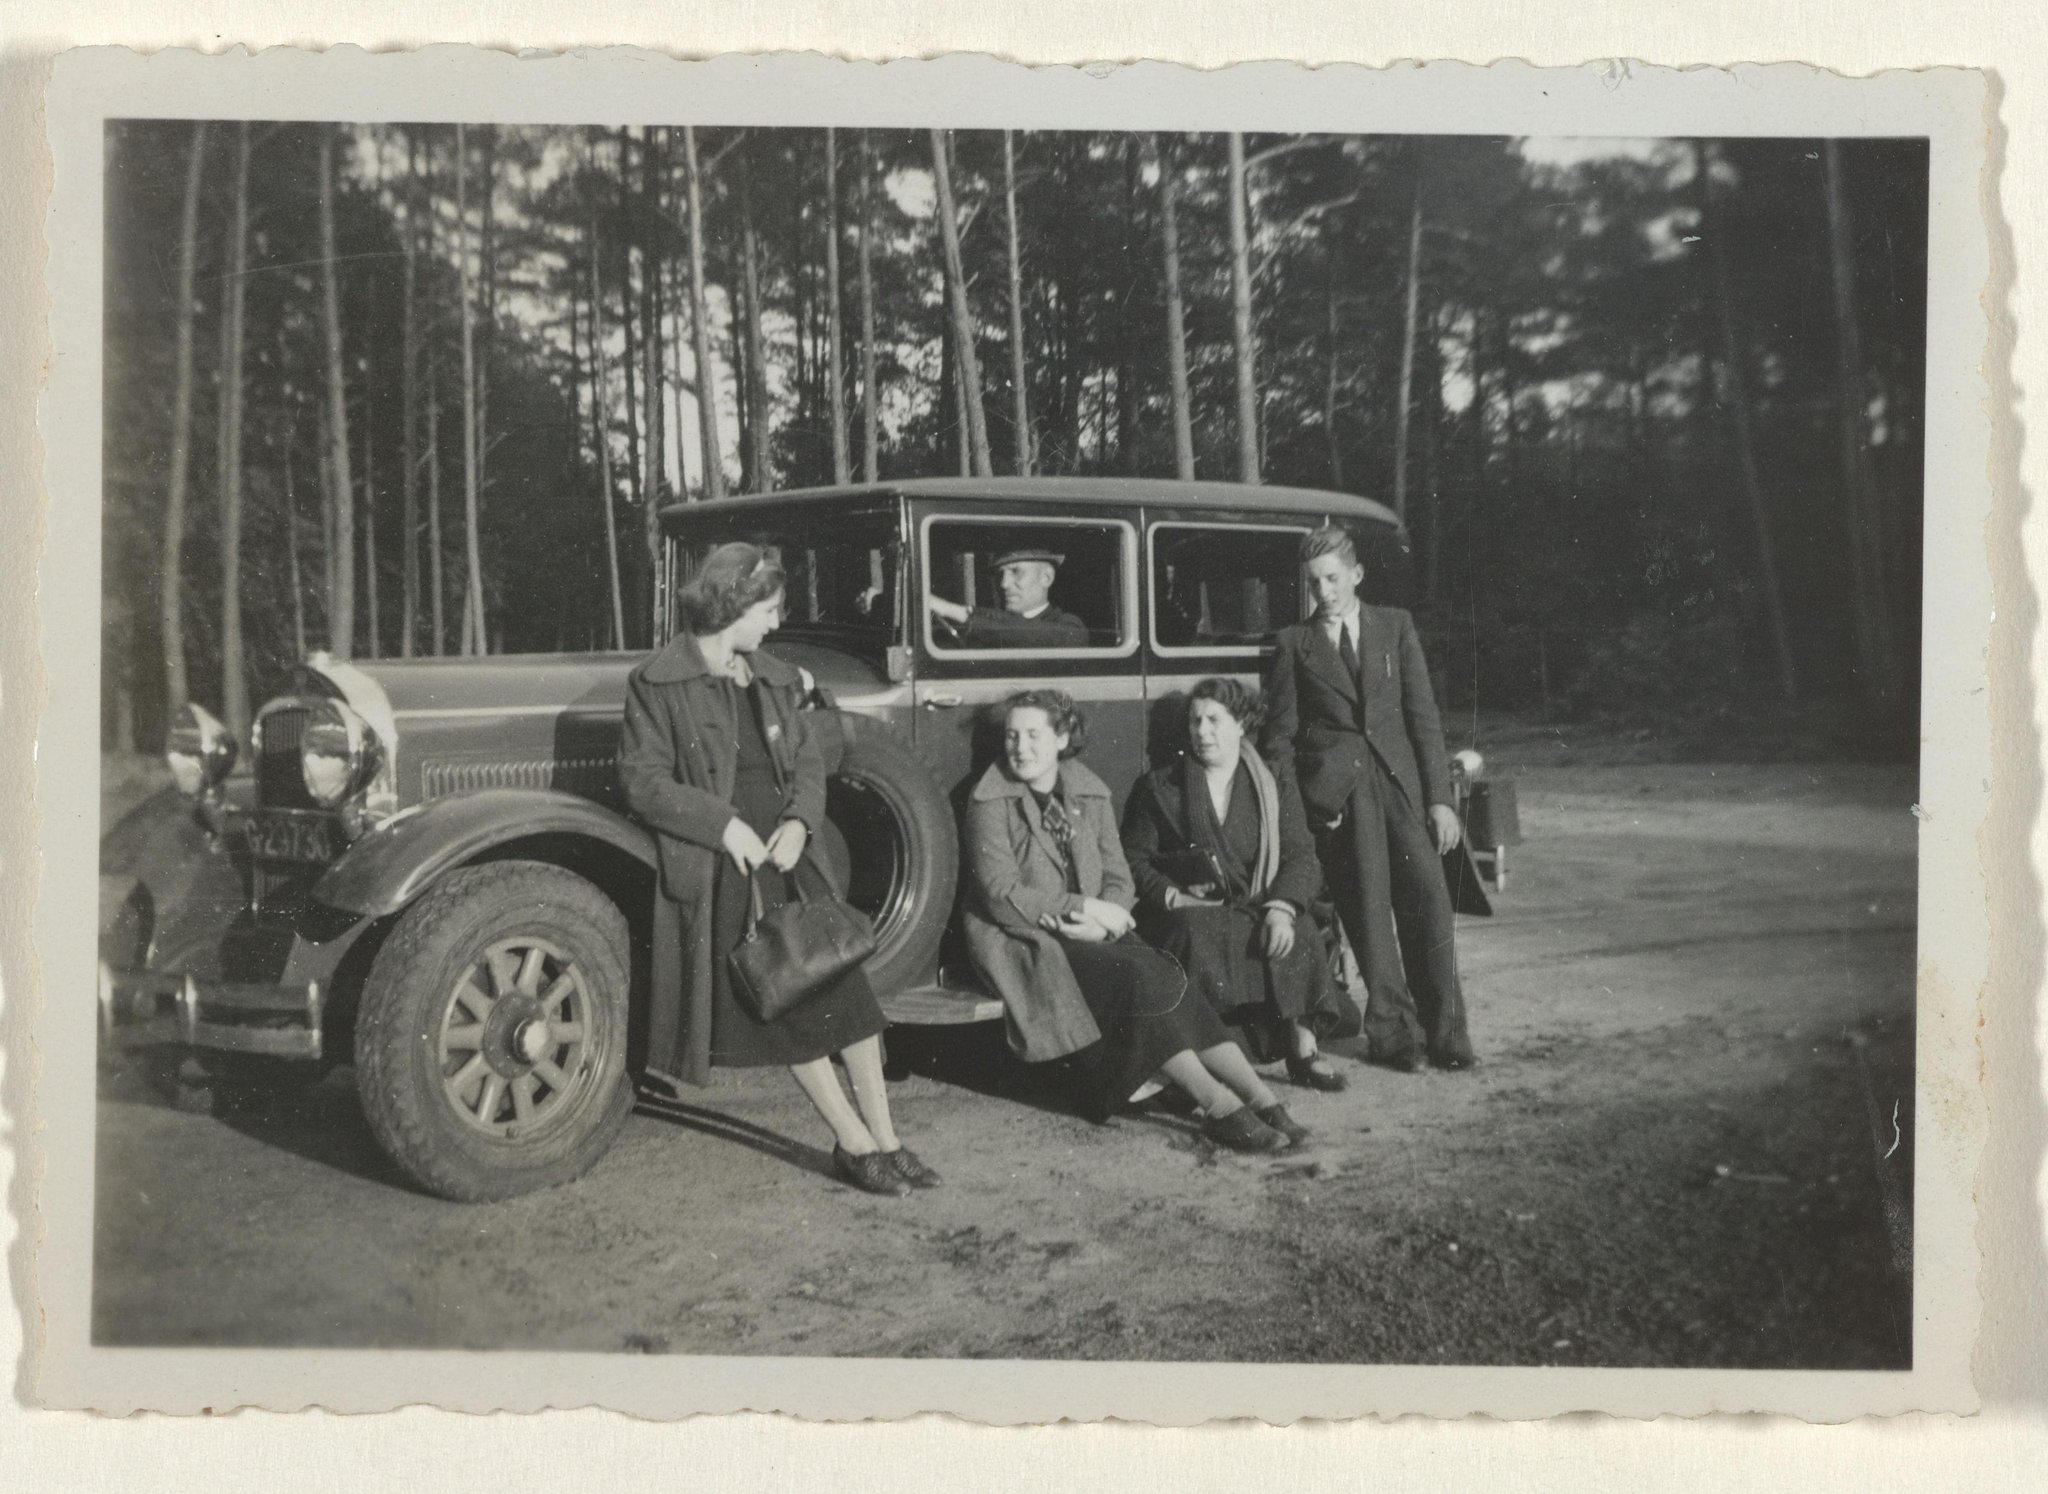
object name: photograph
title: Familie Ochse rondom een auto in het bos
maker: Anonymous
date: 1935-1950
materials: paper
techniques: gelatin silver print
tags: amsterdam, automobile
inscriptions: number: ‘8.’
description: Wilhelm Ochse achter het stuur, v.l.n.r. onbekende vriendin van Daan of Ben, Koosje, Catharina Maria en Ben of Daan.